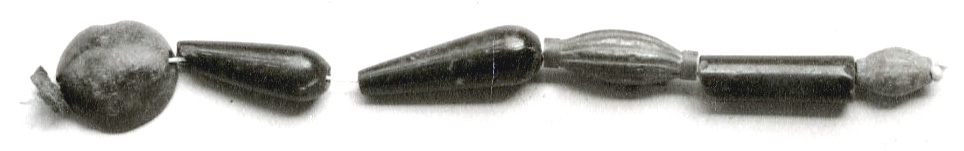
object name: bead, string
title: String of beads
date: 1850-1700 BCE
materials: gemstone, gold, lapis lazuli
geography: egypt